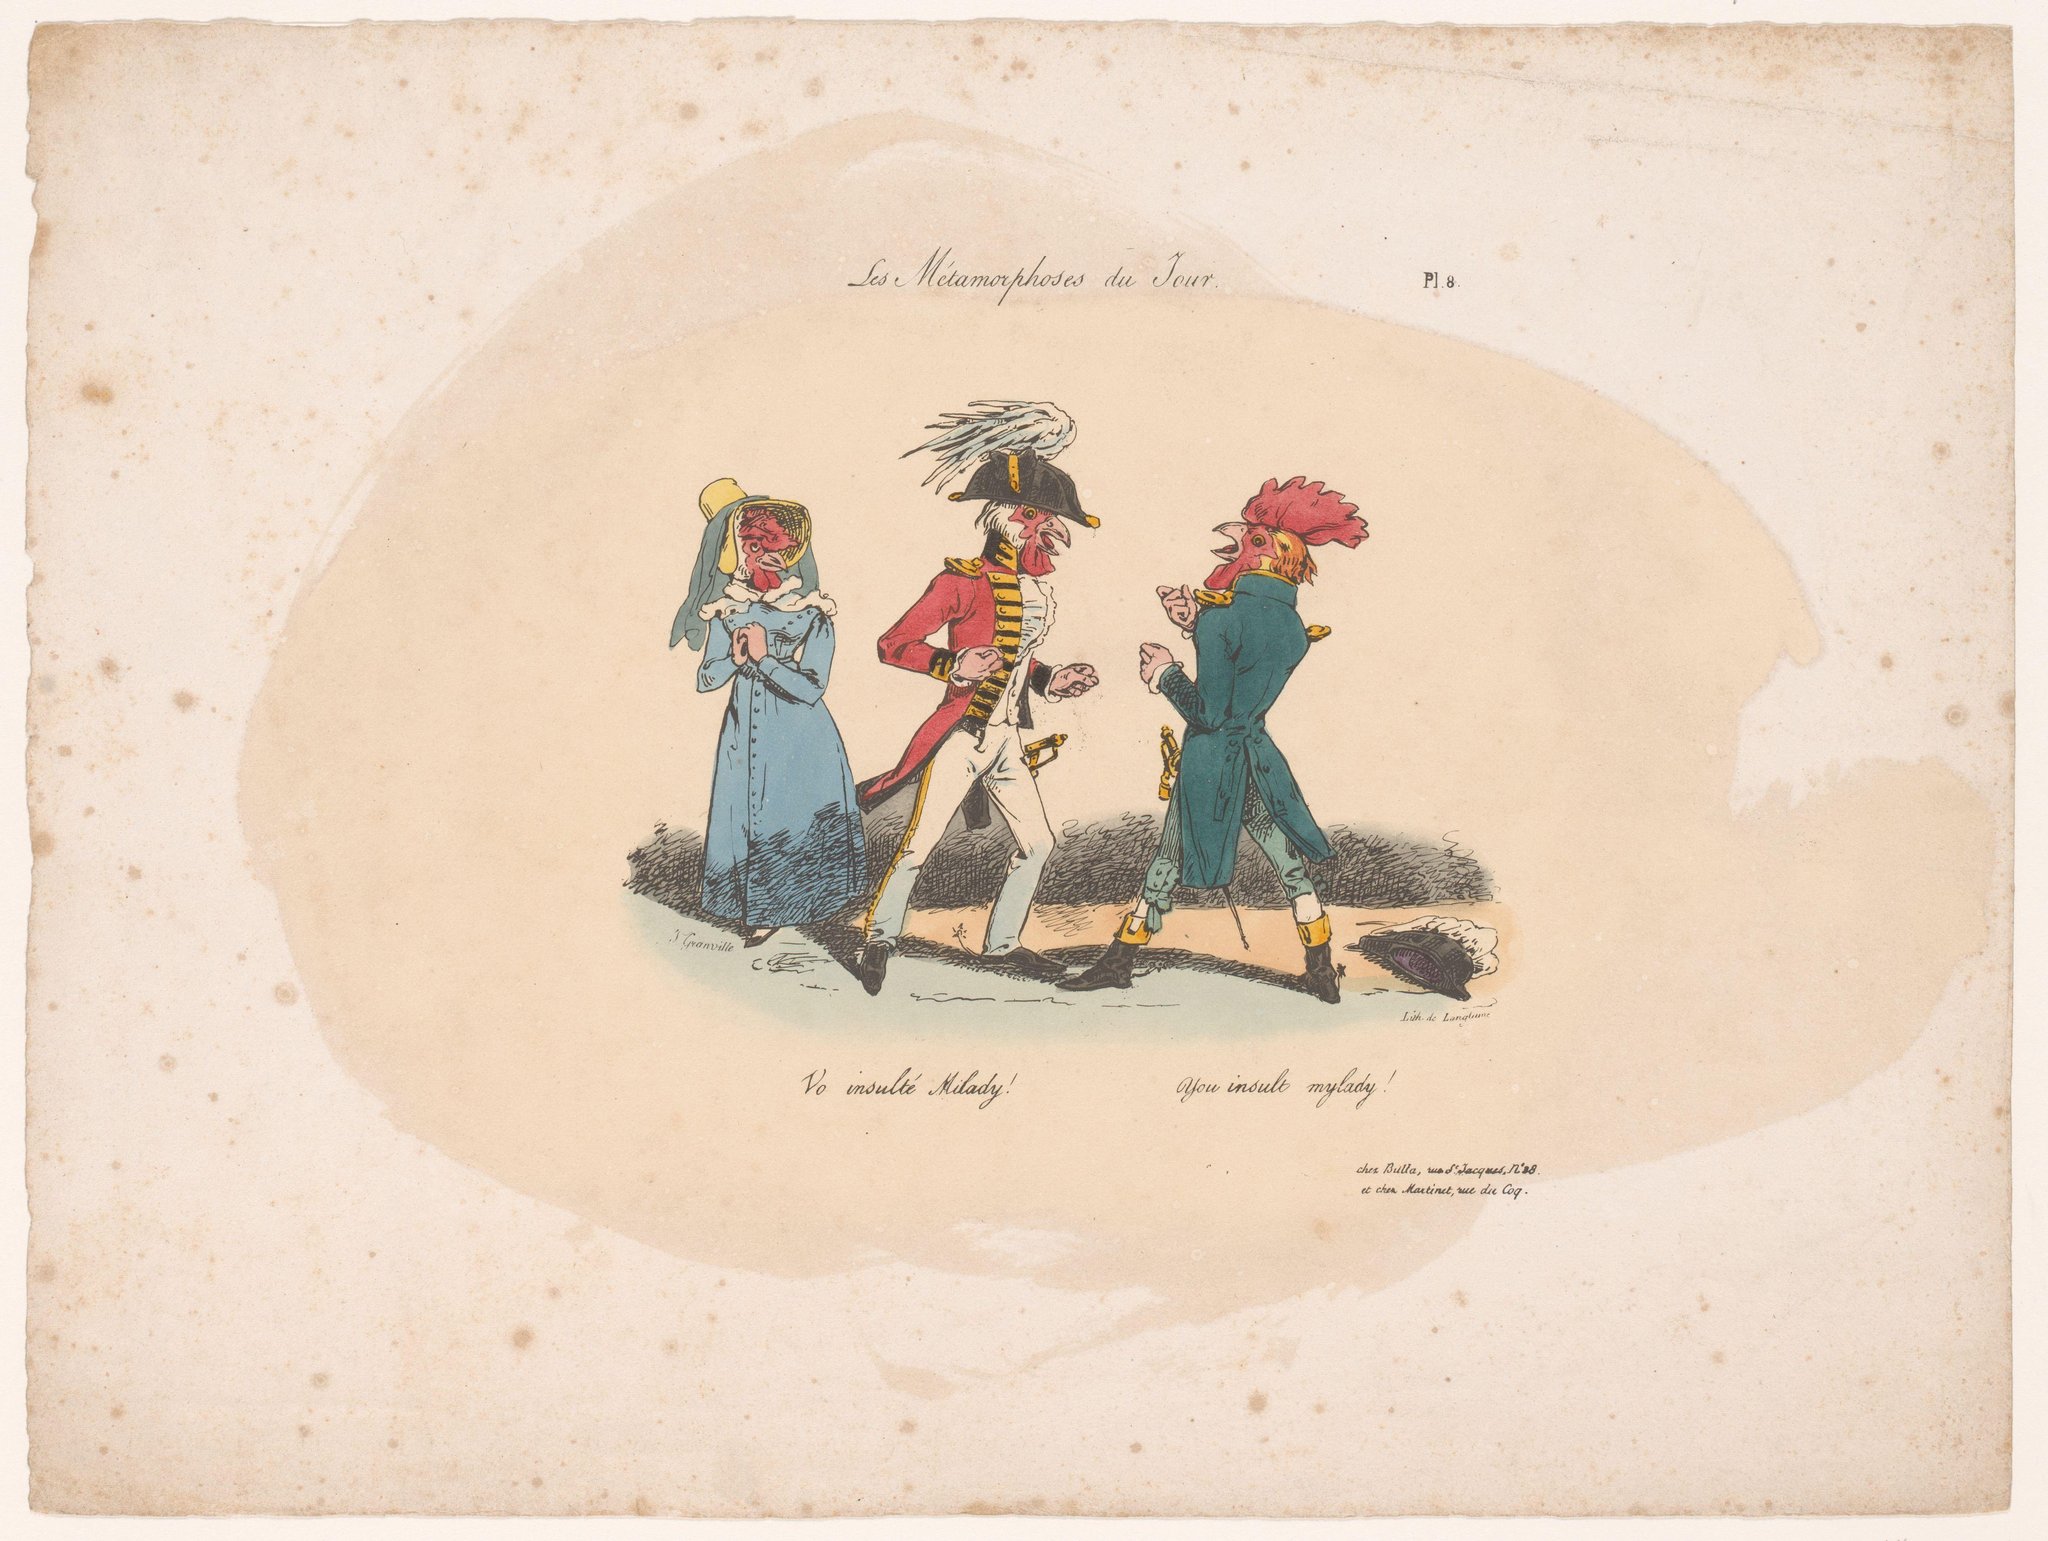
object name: cartoon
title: Twee hanen maken ruzie over een hen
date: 1829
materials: paper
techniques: hand coloring, lithograph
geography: paris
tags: animals acting as human beings, animals (+ animals in caricature), cock-fighting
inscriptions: collector's mark: Lugt 2228a